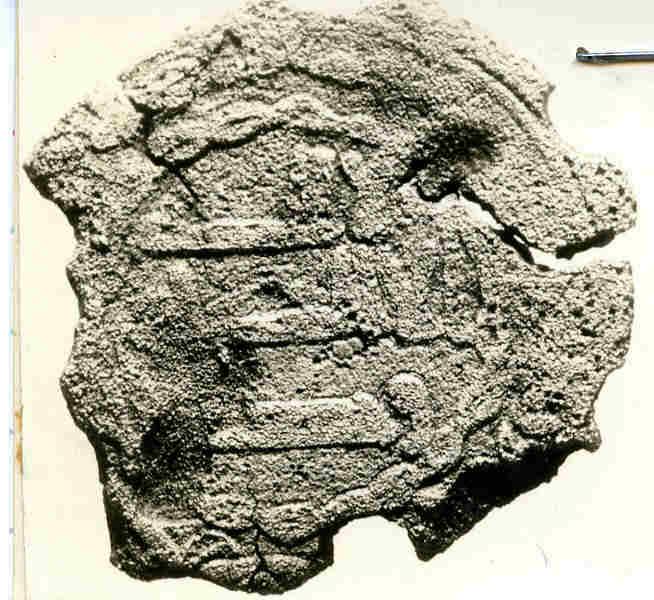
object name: coin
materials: copper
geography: iran